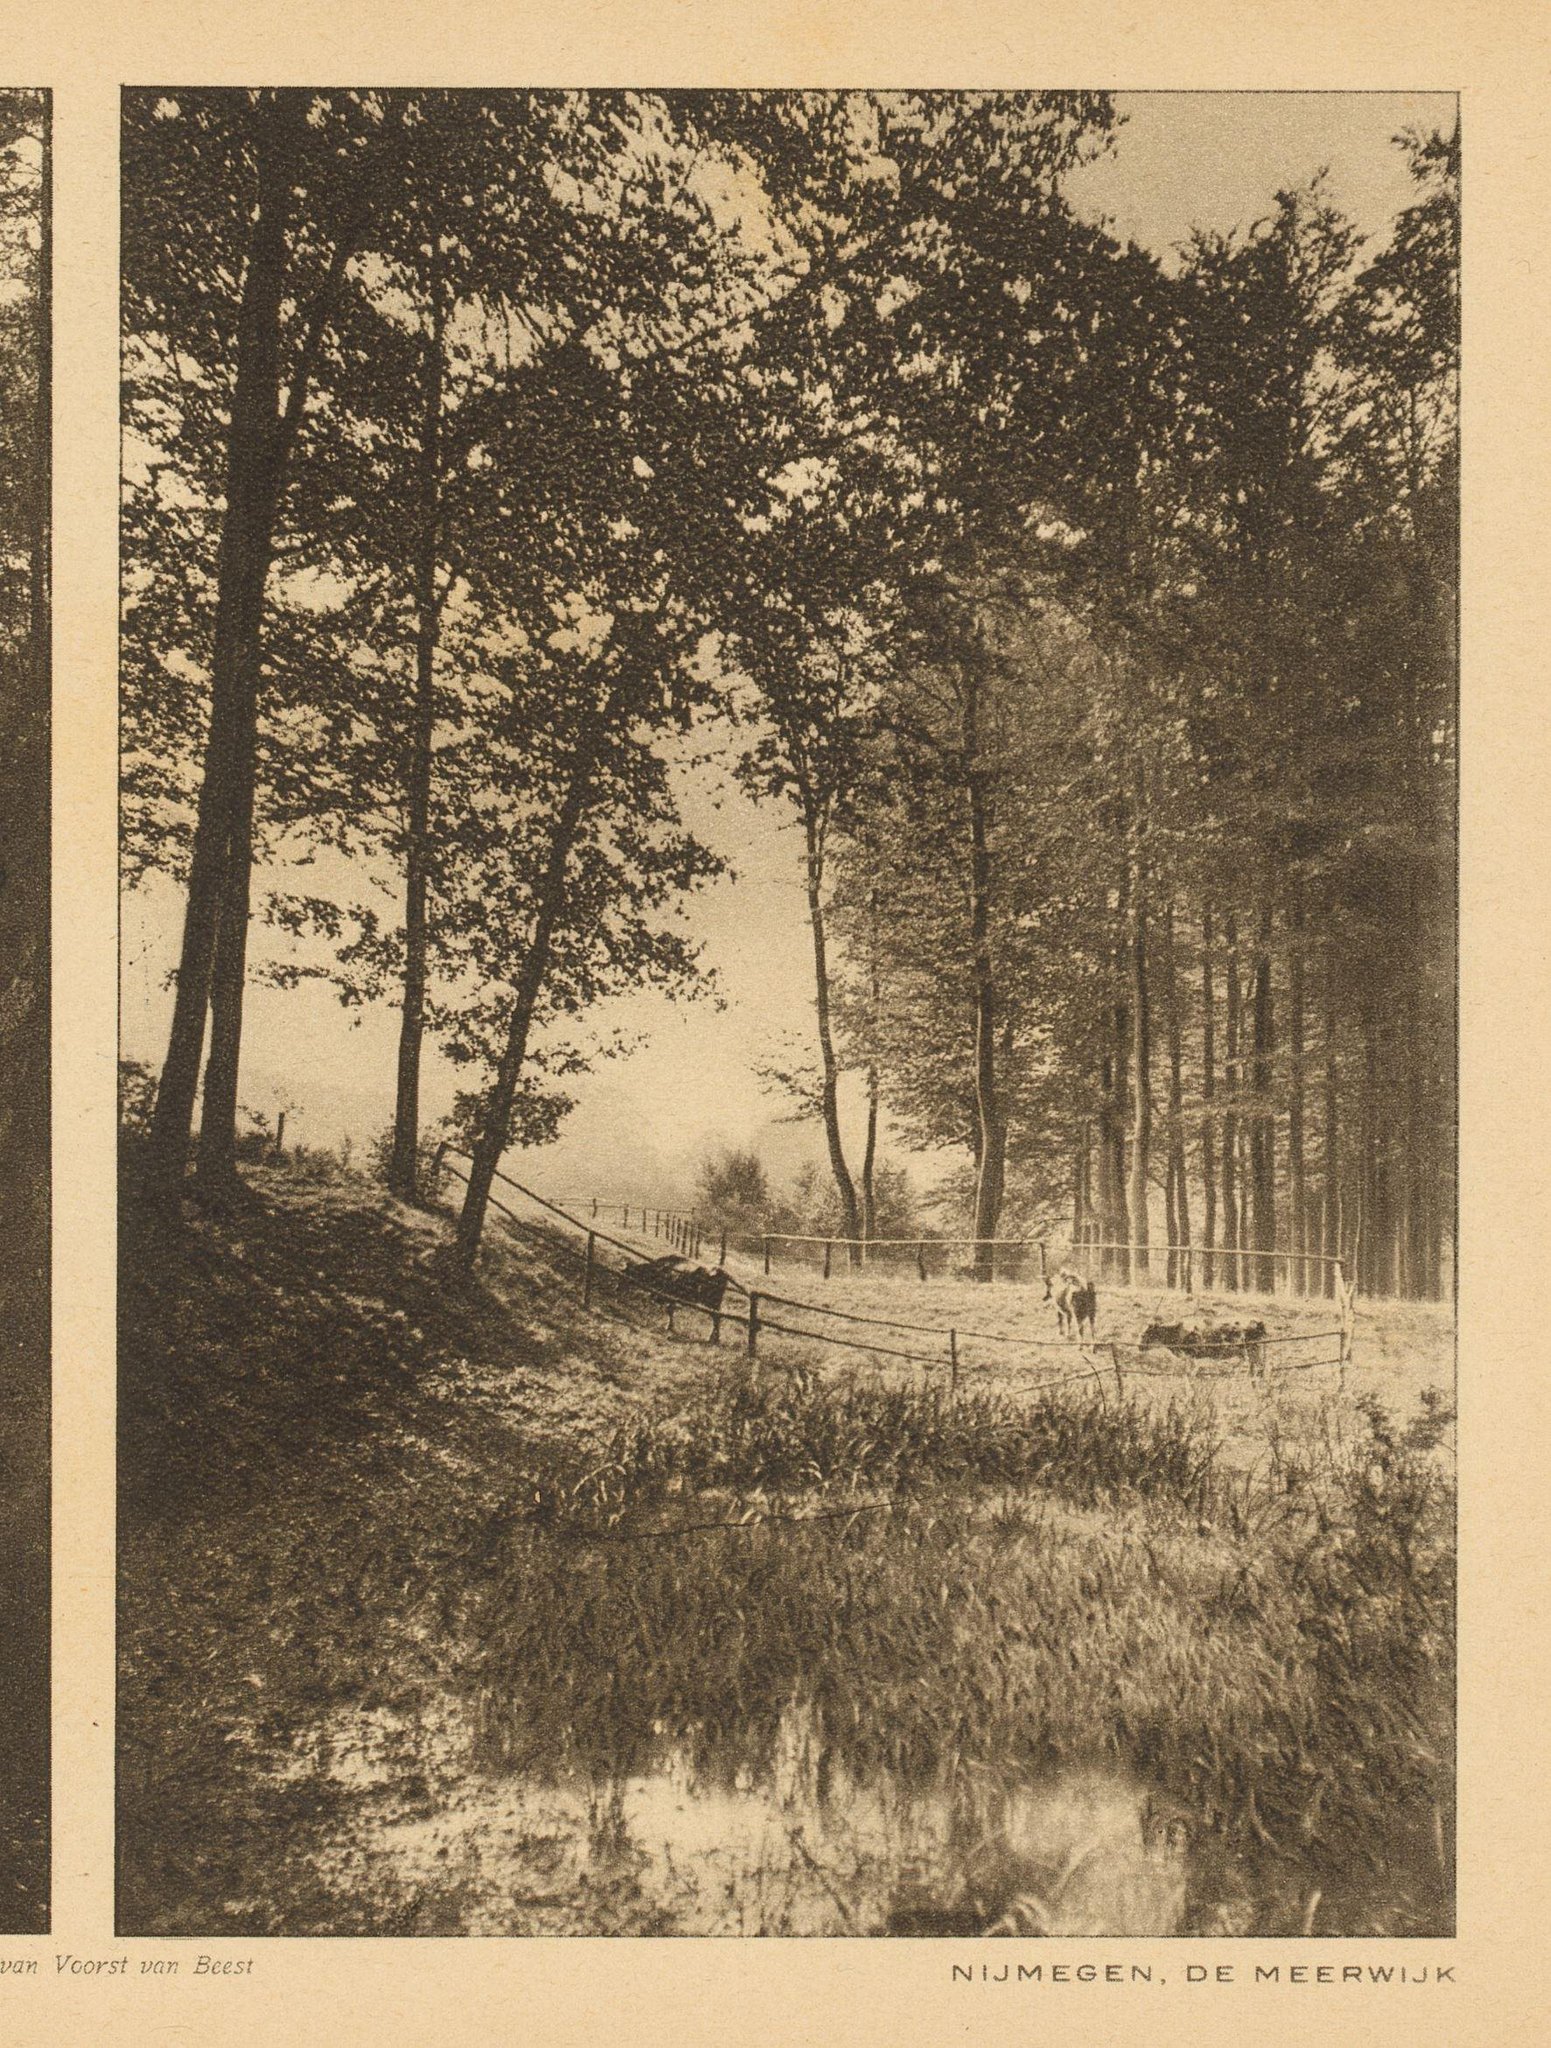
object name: album leaf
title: Gezicht op buurtschap de Meerwijk bij Berg en Dal, Gelderland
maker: jan pieter voorst van beest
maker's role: fotograaf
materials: paper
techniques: rotogravure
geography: leiden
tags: landscapes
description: Deze prent maakt deel uit van een album.